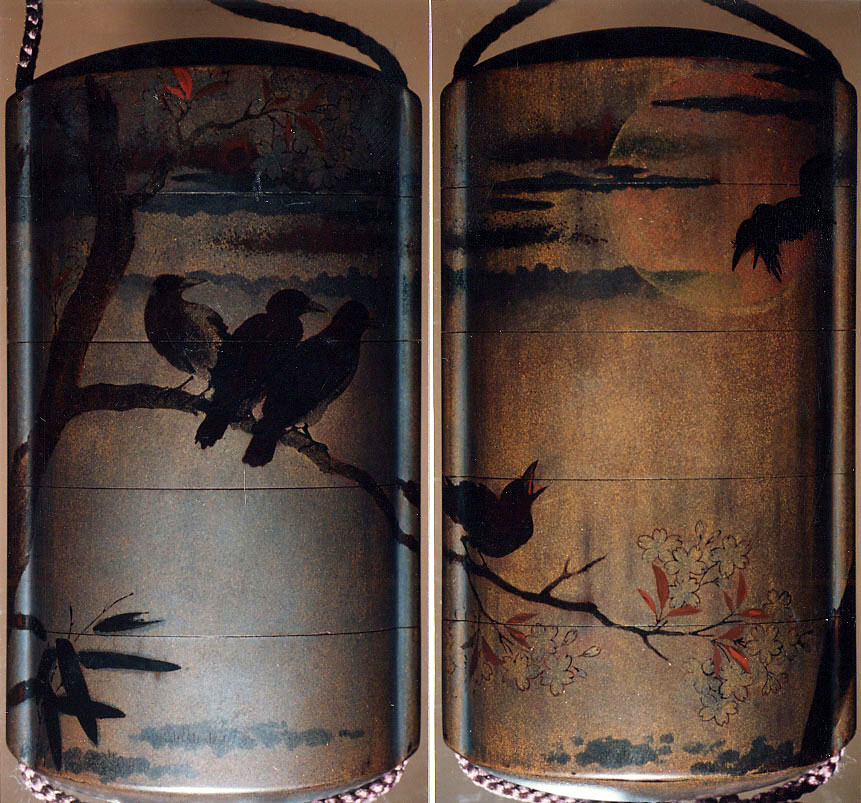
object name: inrō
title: Inrō with Crows on Cherry Tree in Moonlight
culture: japanese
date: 1701-1900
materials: gold, ivory, lacquer, silver, wood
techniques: carving, enamel, lacquer, maki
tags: birds,moon,trees,night